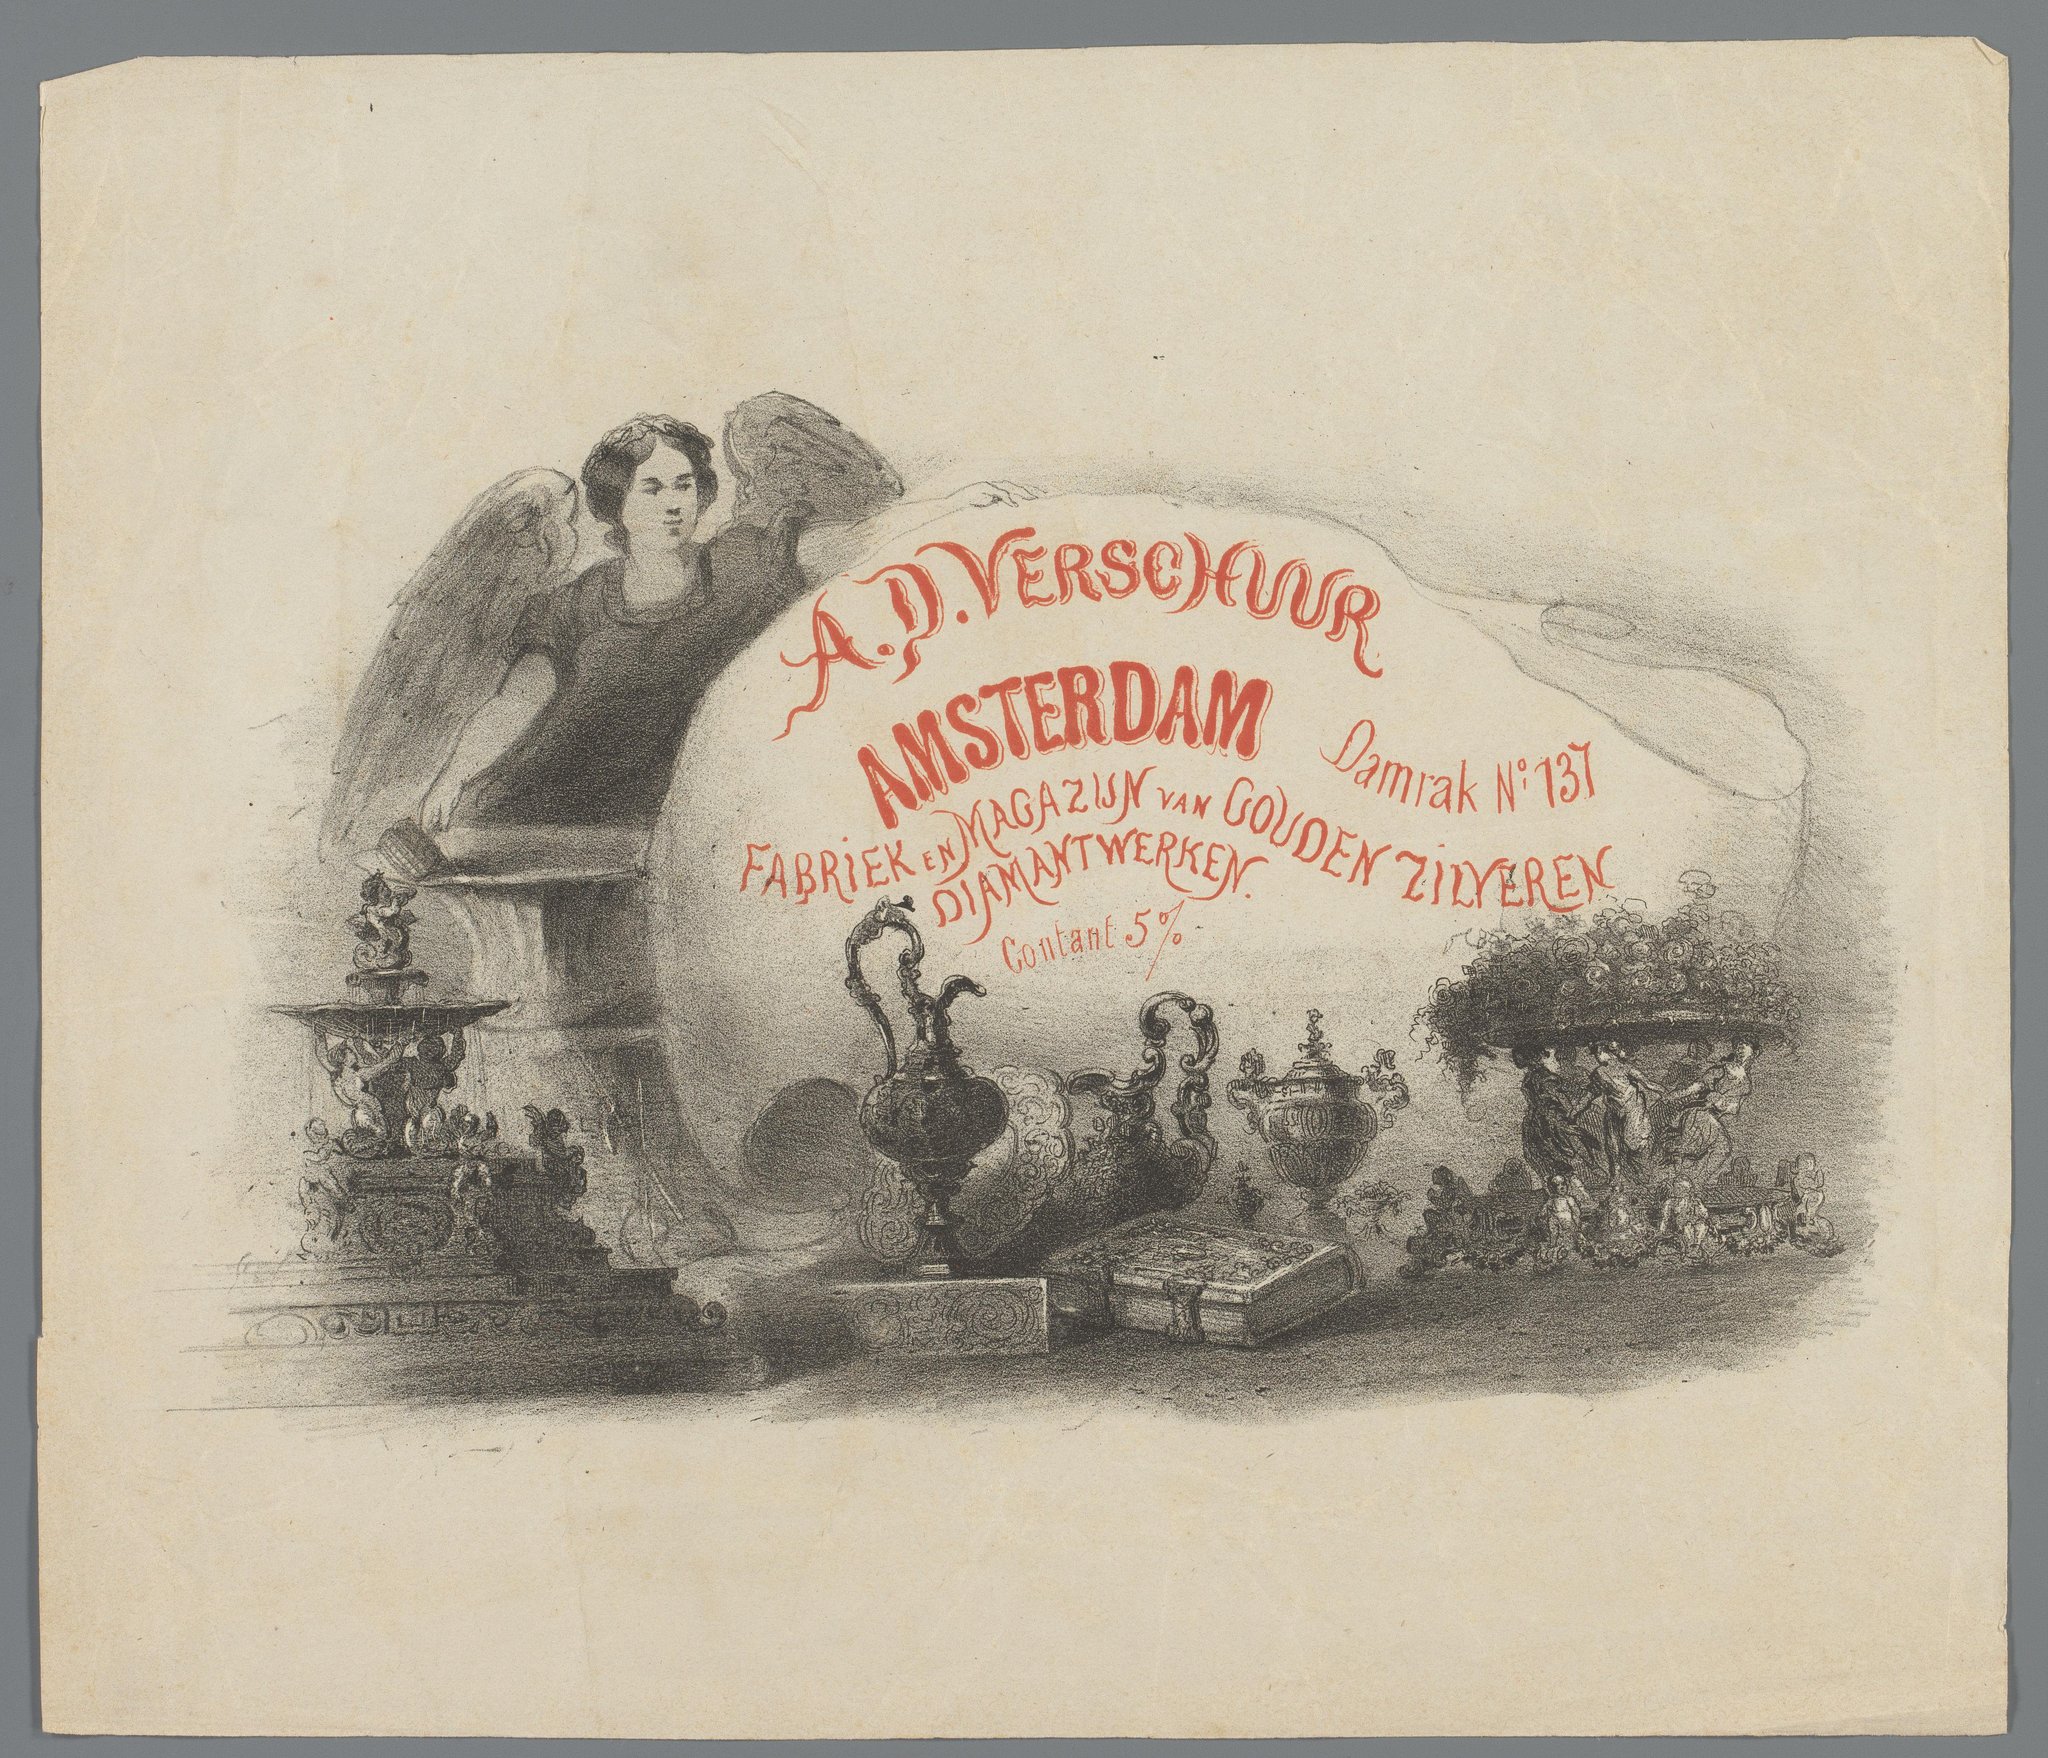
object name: advertisement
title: Advertentie voor edelsmid A.D. Verschuur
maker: Anonymous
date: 1848-1884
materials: paper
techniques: lithograph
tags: anthonie daniël verschuur, book, angels, container of precious metal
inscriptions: collector's mark: Lugt 2233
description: Een engel houdt een laken op, met daarop de tekst: 'A.D. Verschuur Amsterdam Damrak no. 137. Fabriek en Magazijnen van gouden, zilveren, diamantwerken. Contant 5%'. Daarvoor objecten en gereedschap uit de edelsmederij.